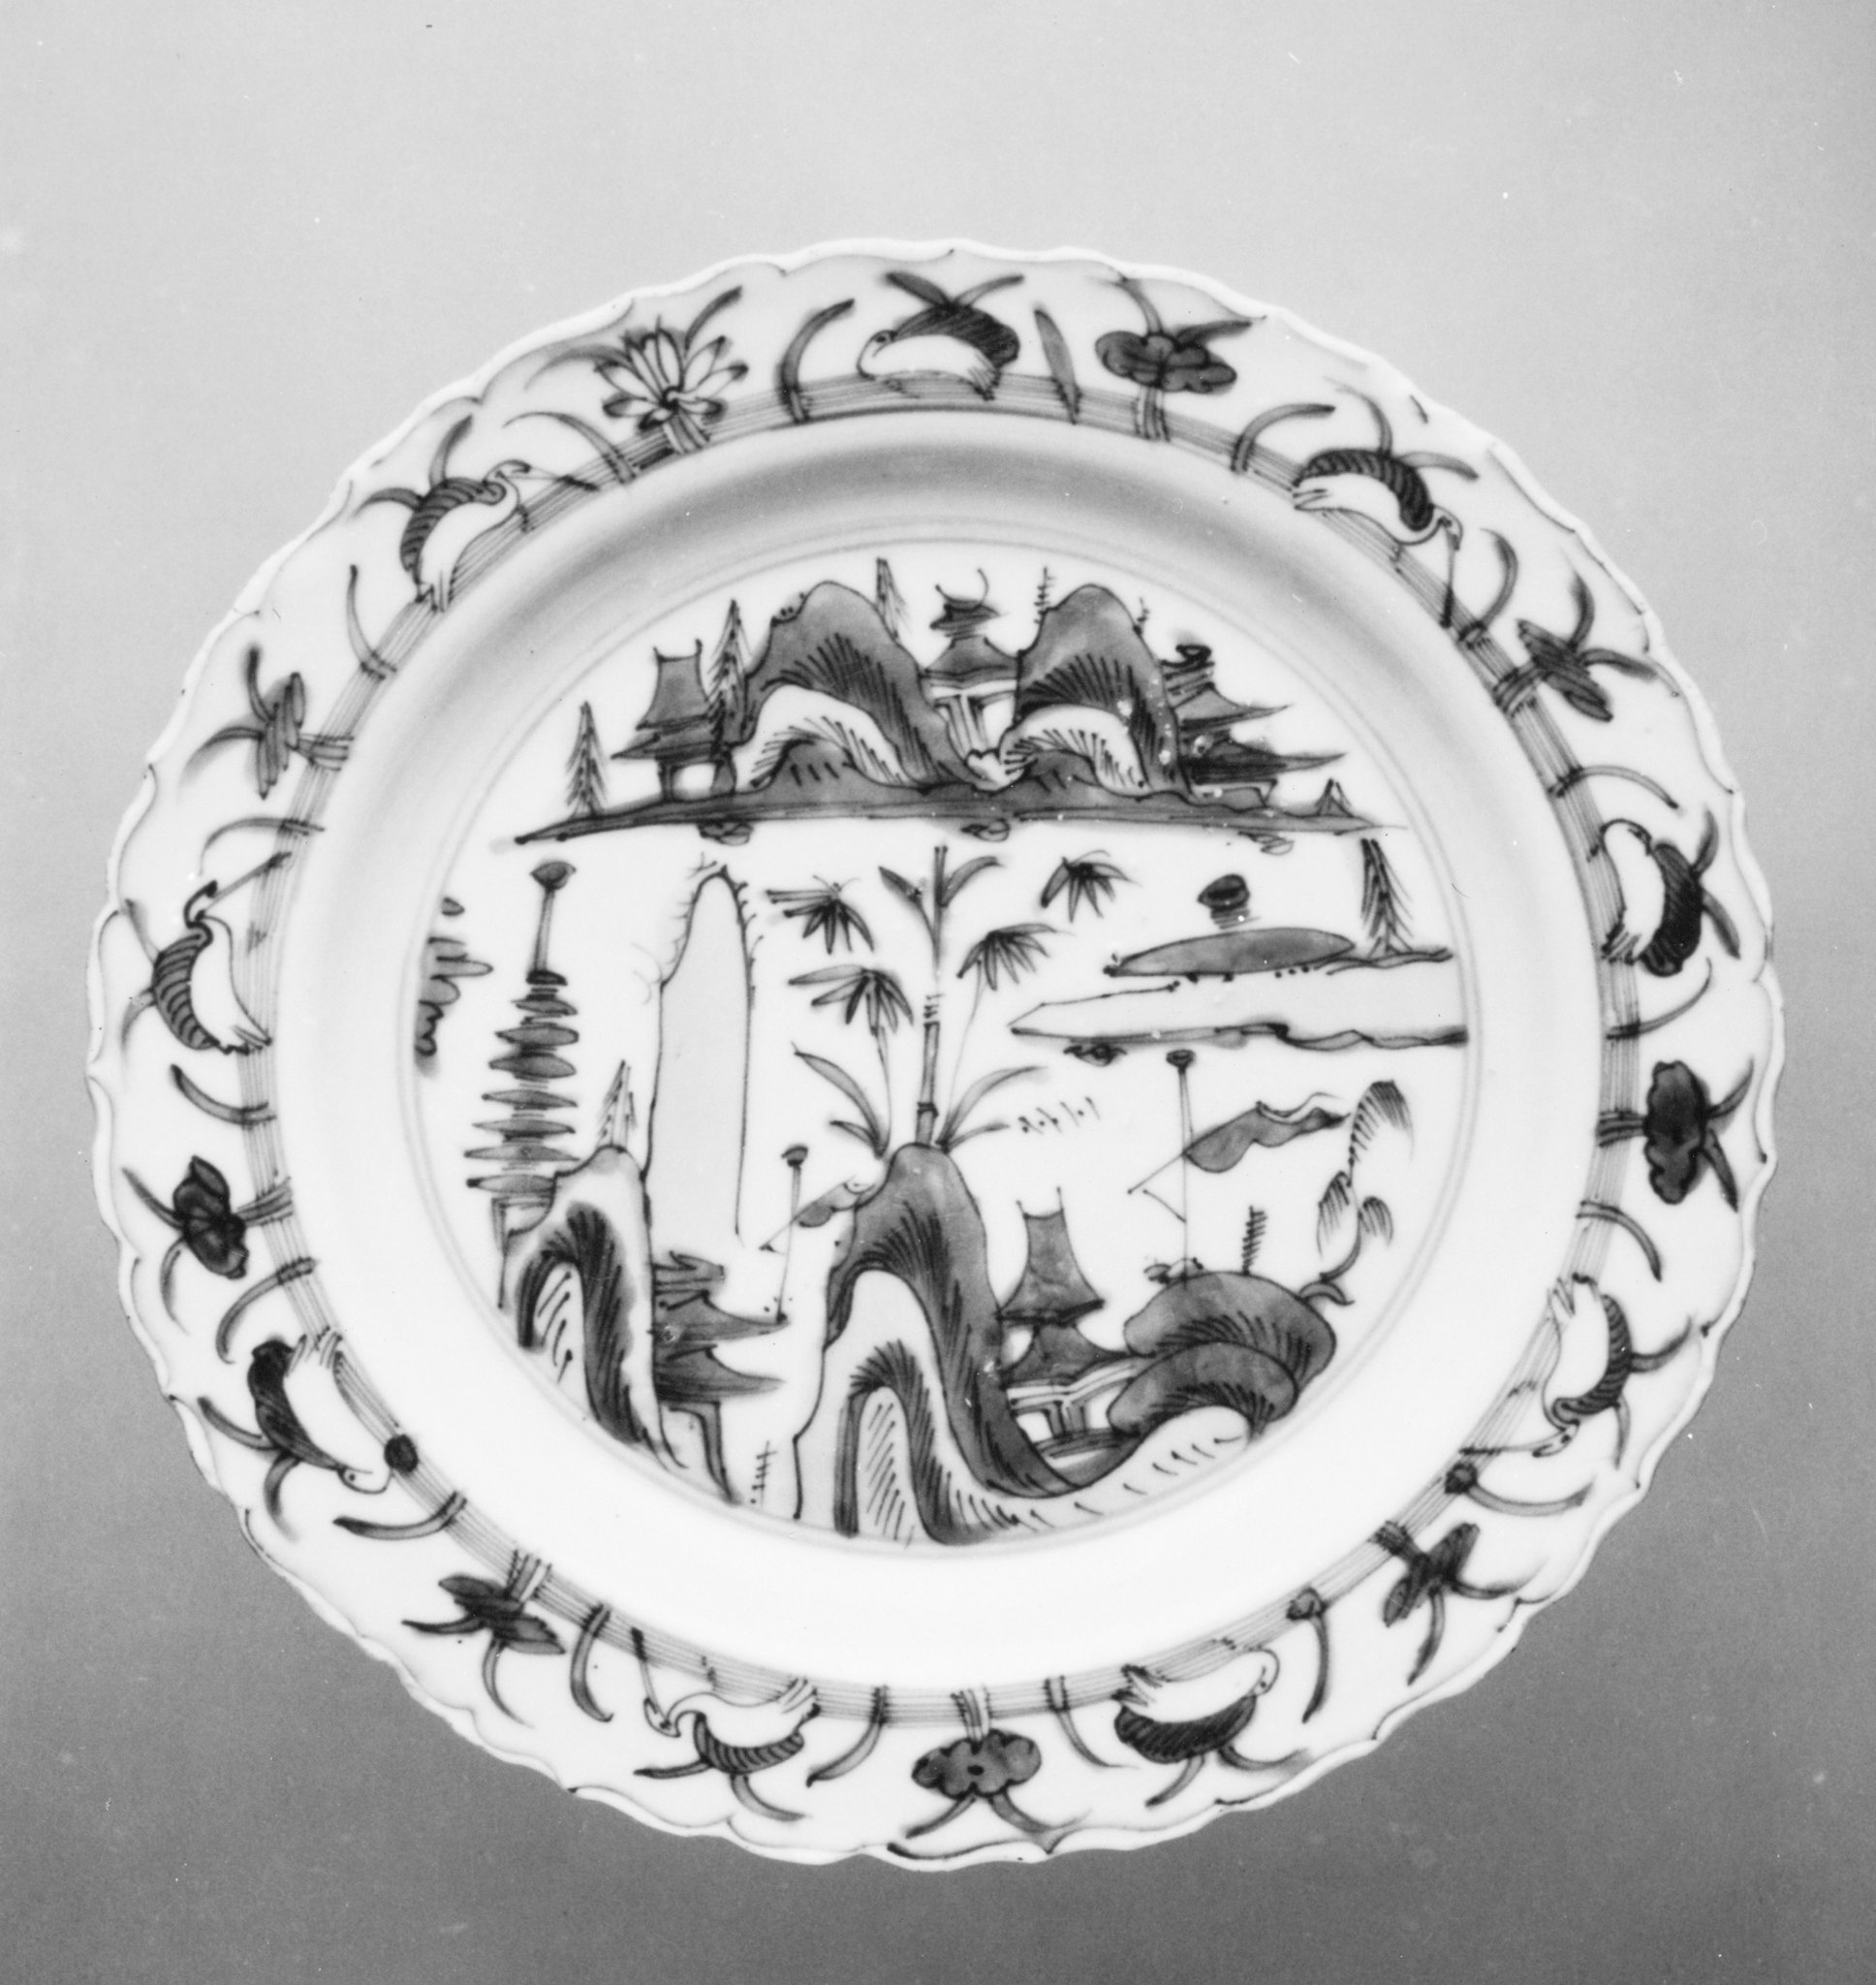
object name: plate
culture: chinese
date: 1368-1644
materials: porcelain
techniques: painting, underglaze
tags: birds,flowers,leaves